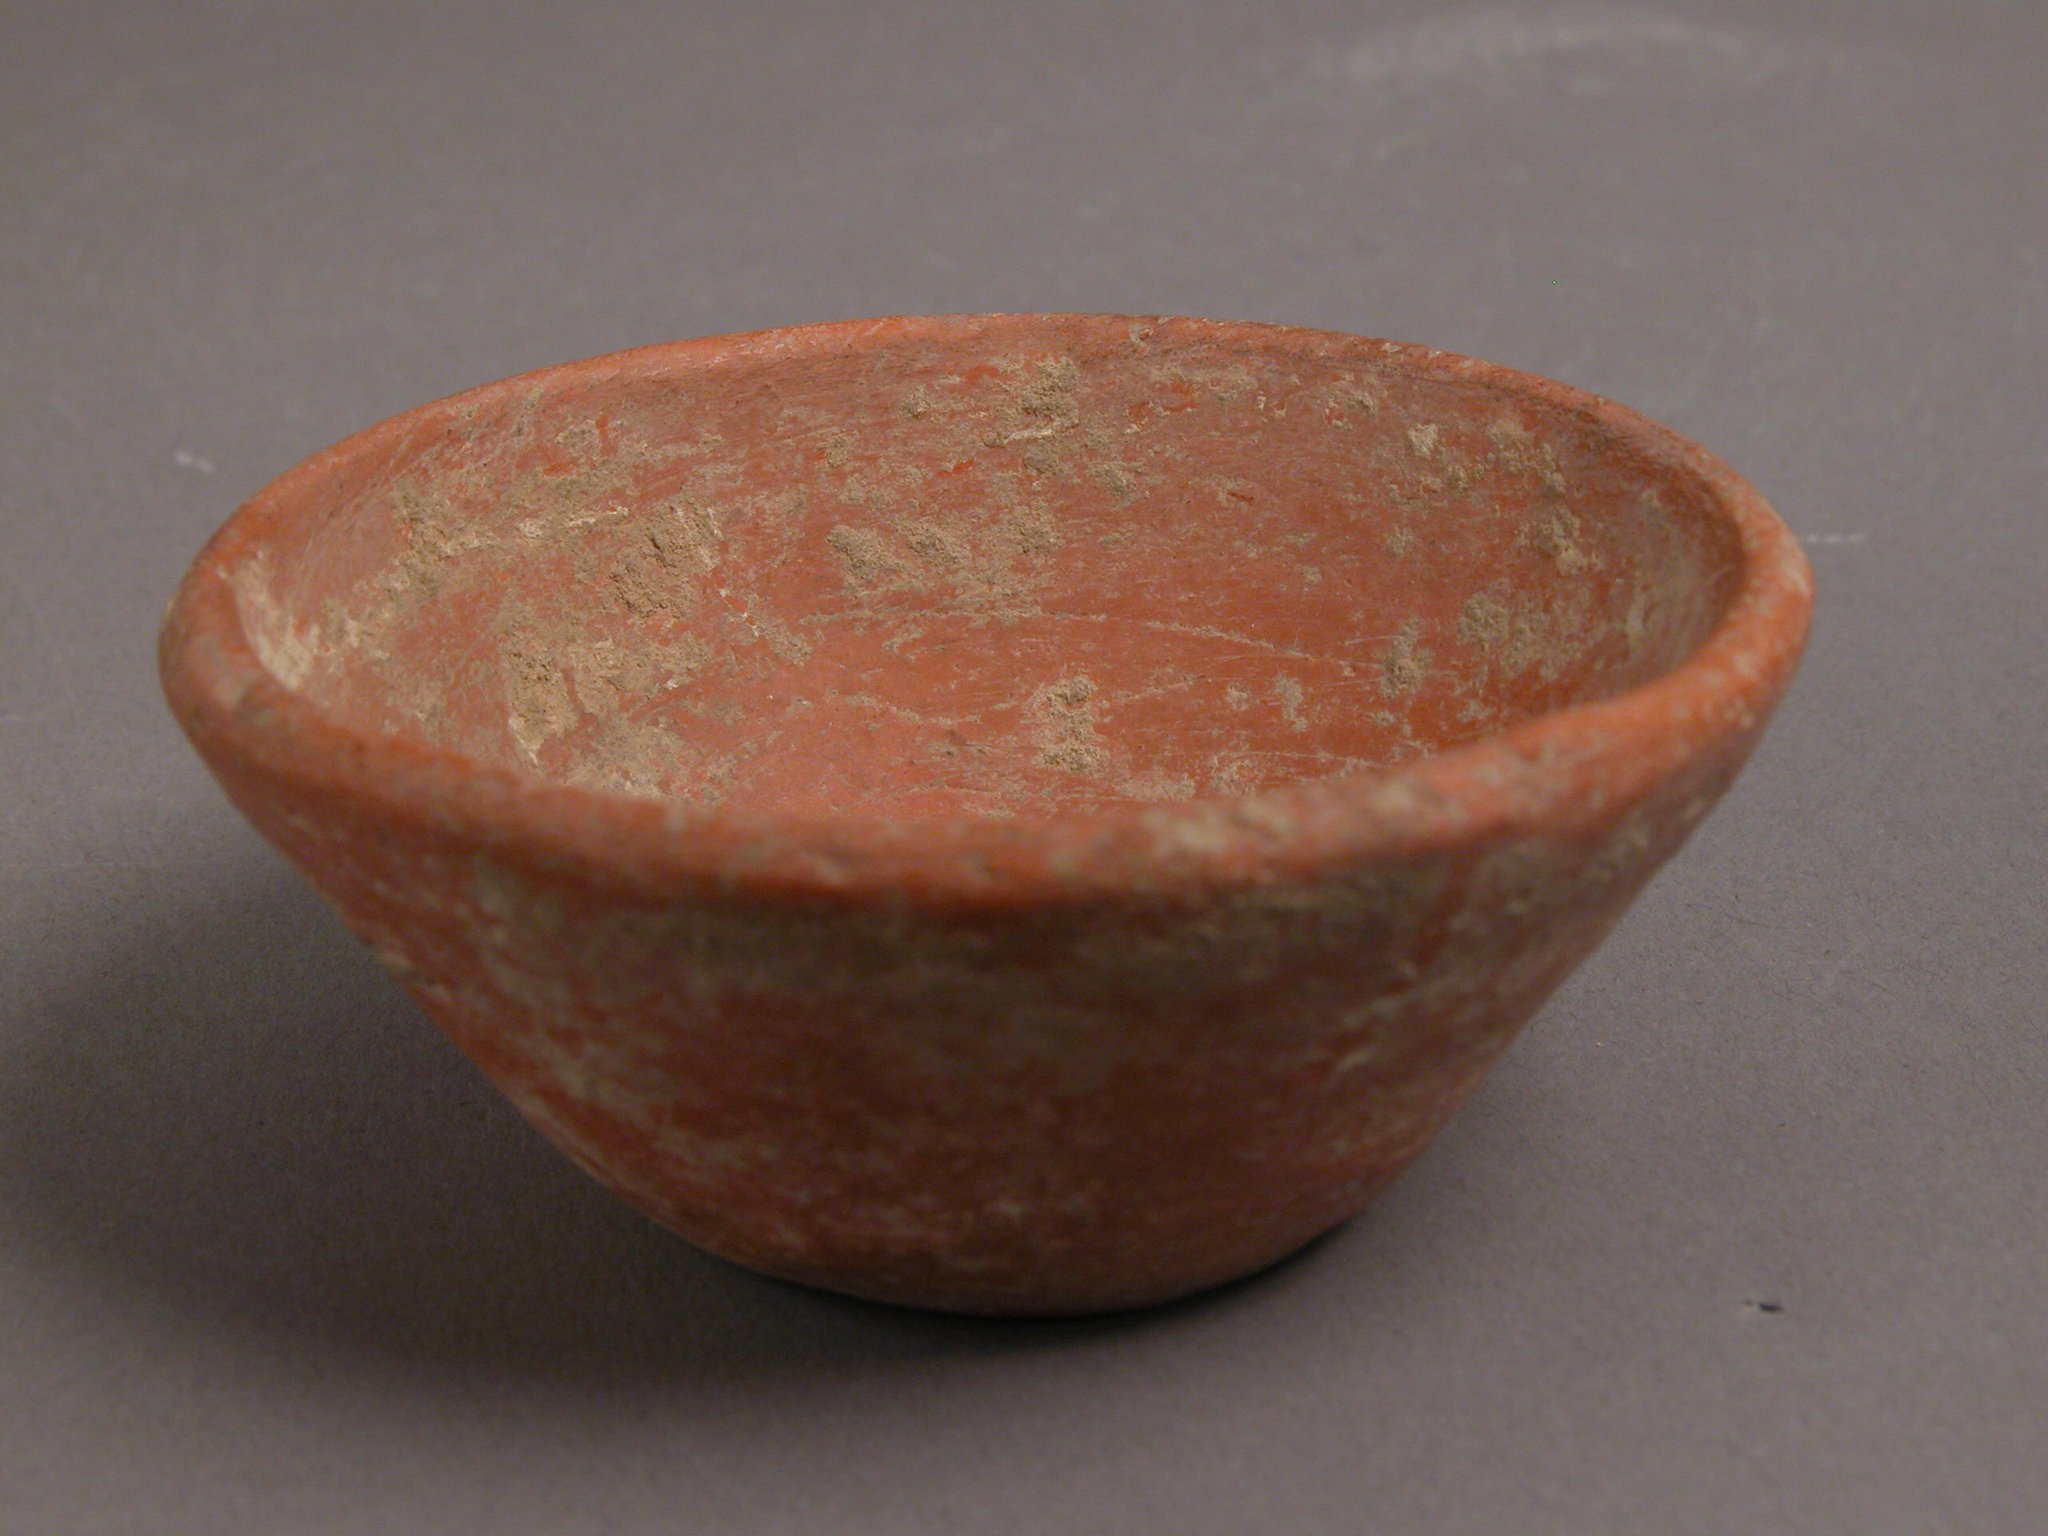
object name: bowl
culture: coptic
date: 301-700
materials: earthenware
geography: egypt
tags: bowls